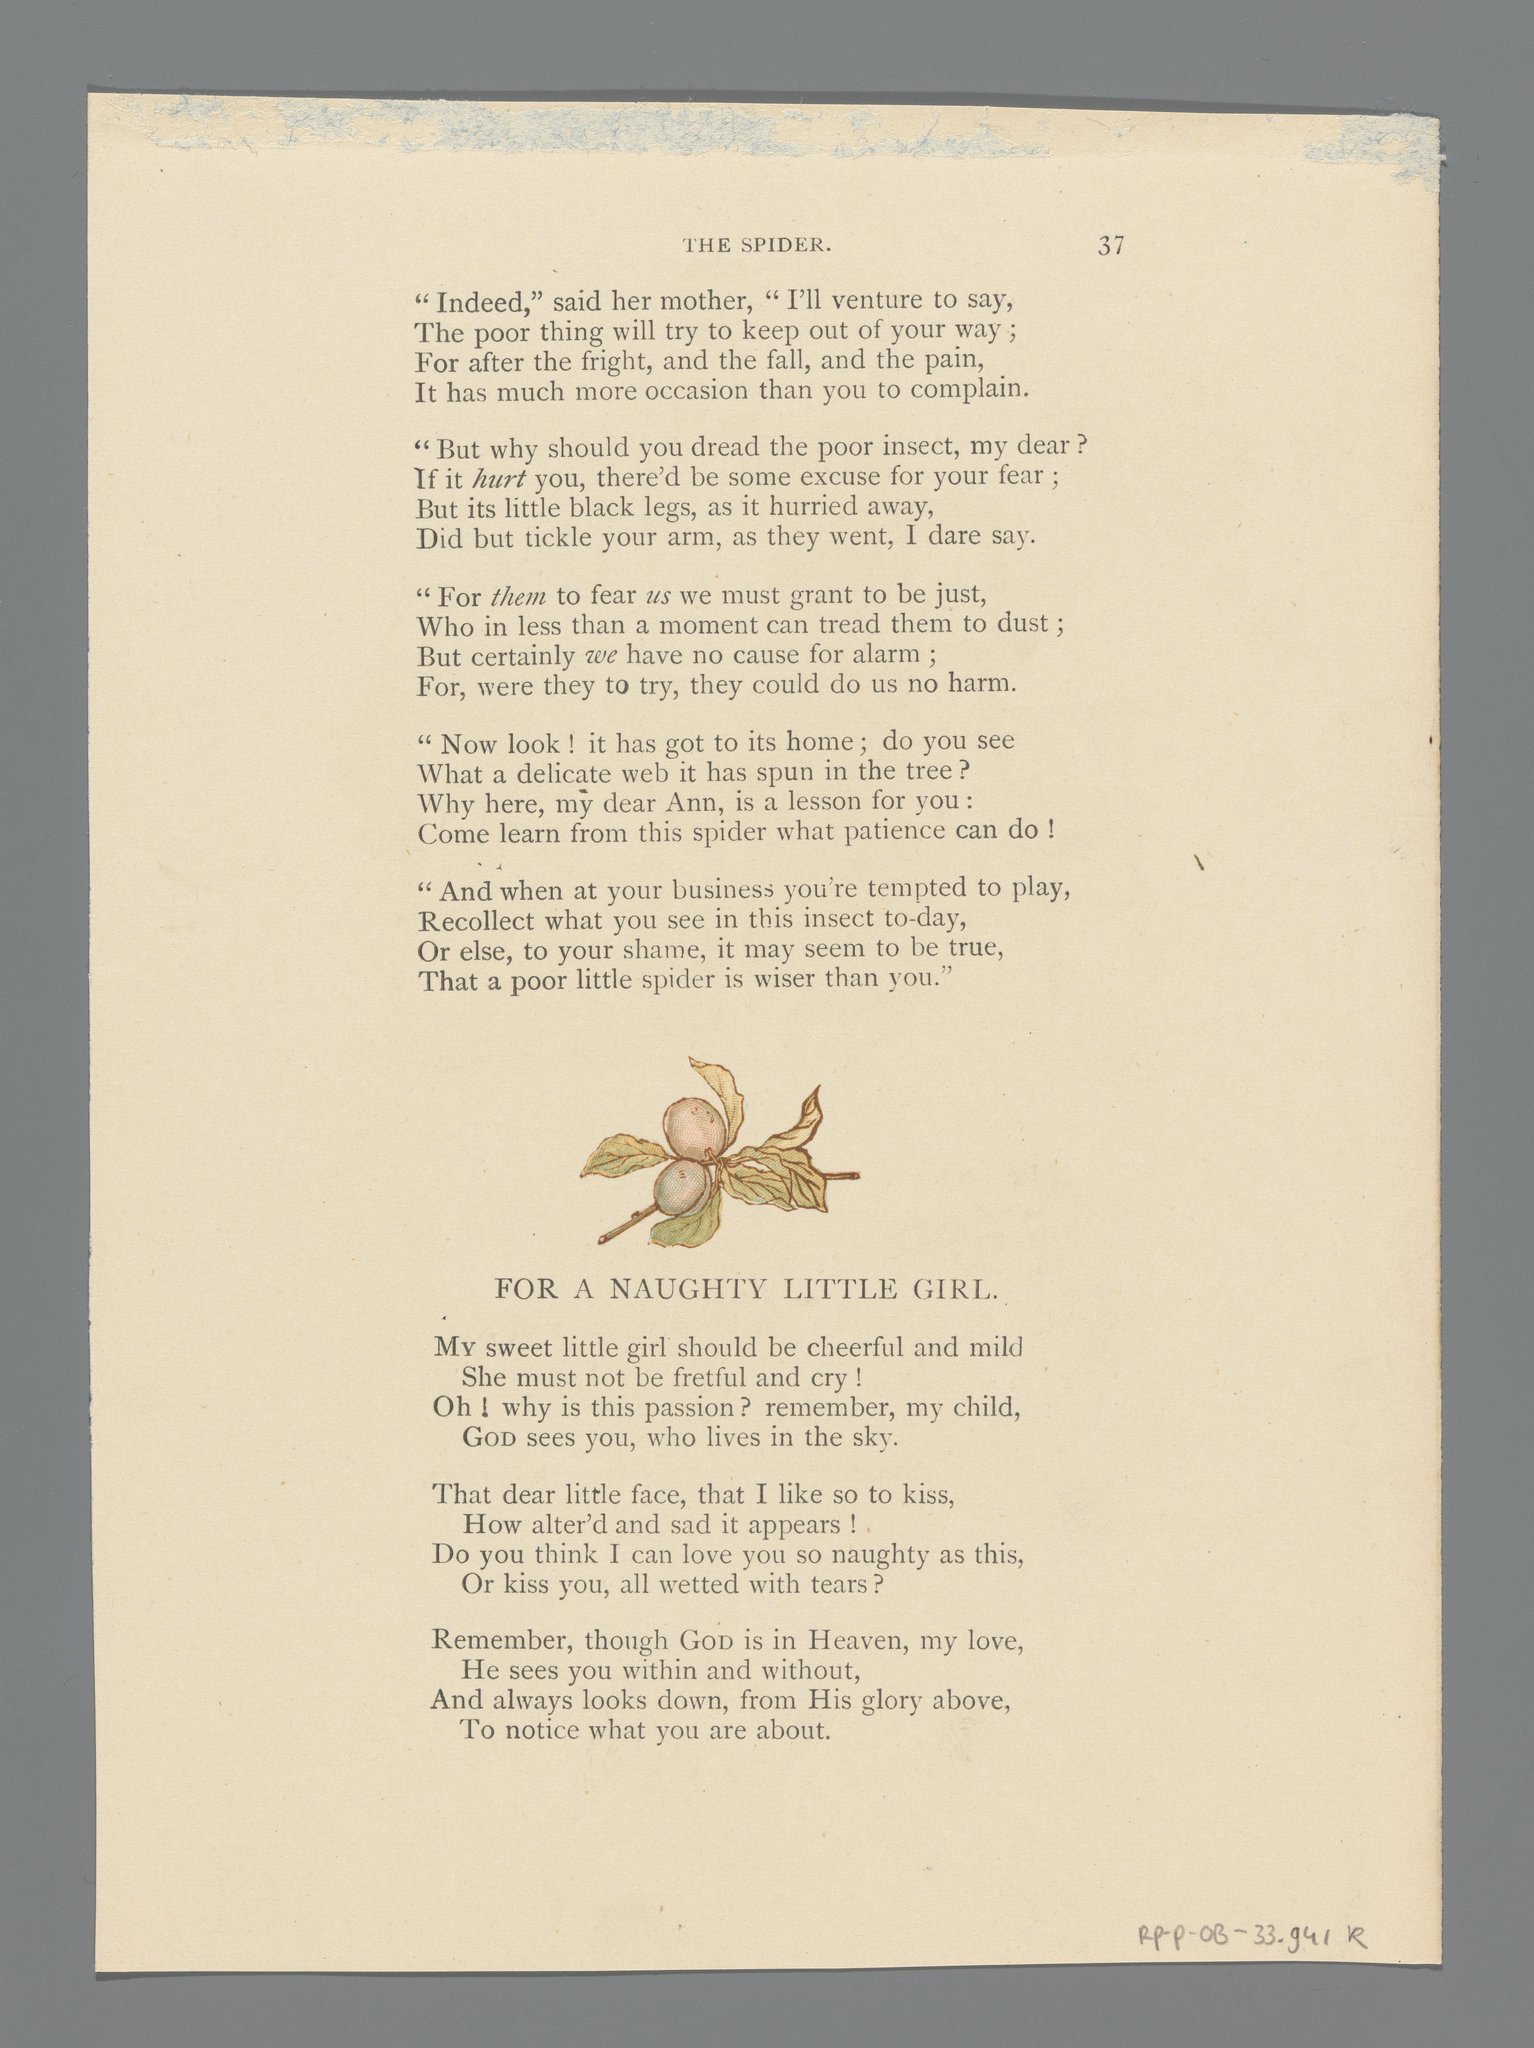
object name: book illustration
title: Tak met vruchten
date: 1883-1927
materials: paper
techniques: wood engraving, letterpress printing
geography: london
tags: fruits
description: Prent uit: Jane en Ann Taylor. Little Ann and other poems. Londen: George Routledge & Sons, [1883], p. 37. Of een latere uitgave.